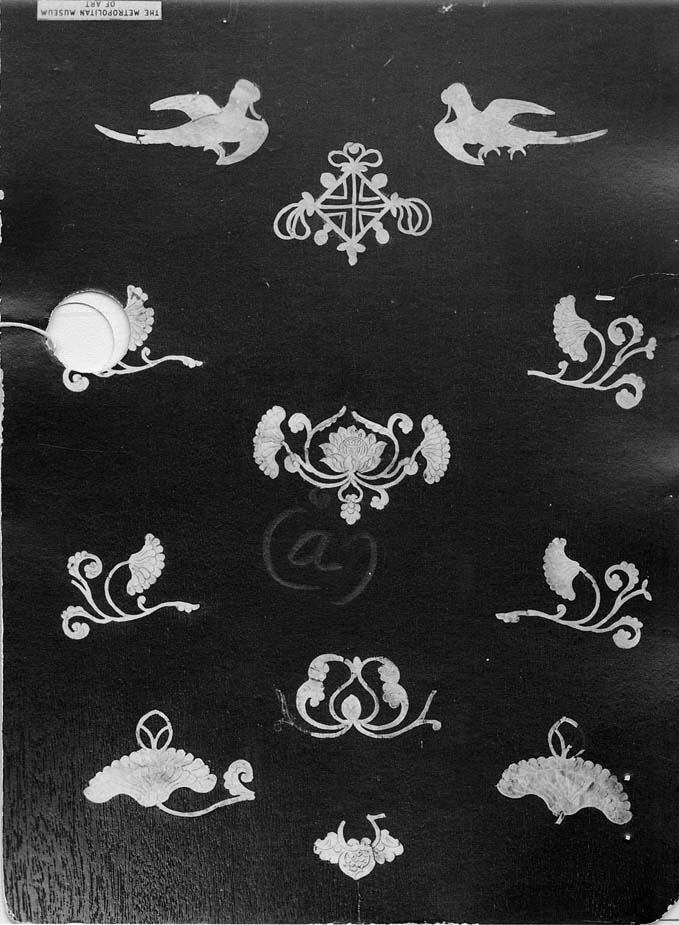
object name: ornament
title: Ornaments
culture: chinese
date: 618-907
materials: silver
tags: flowers